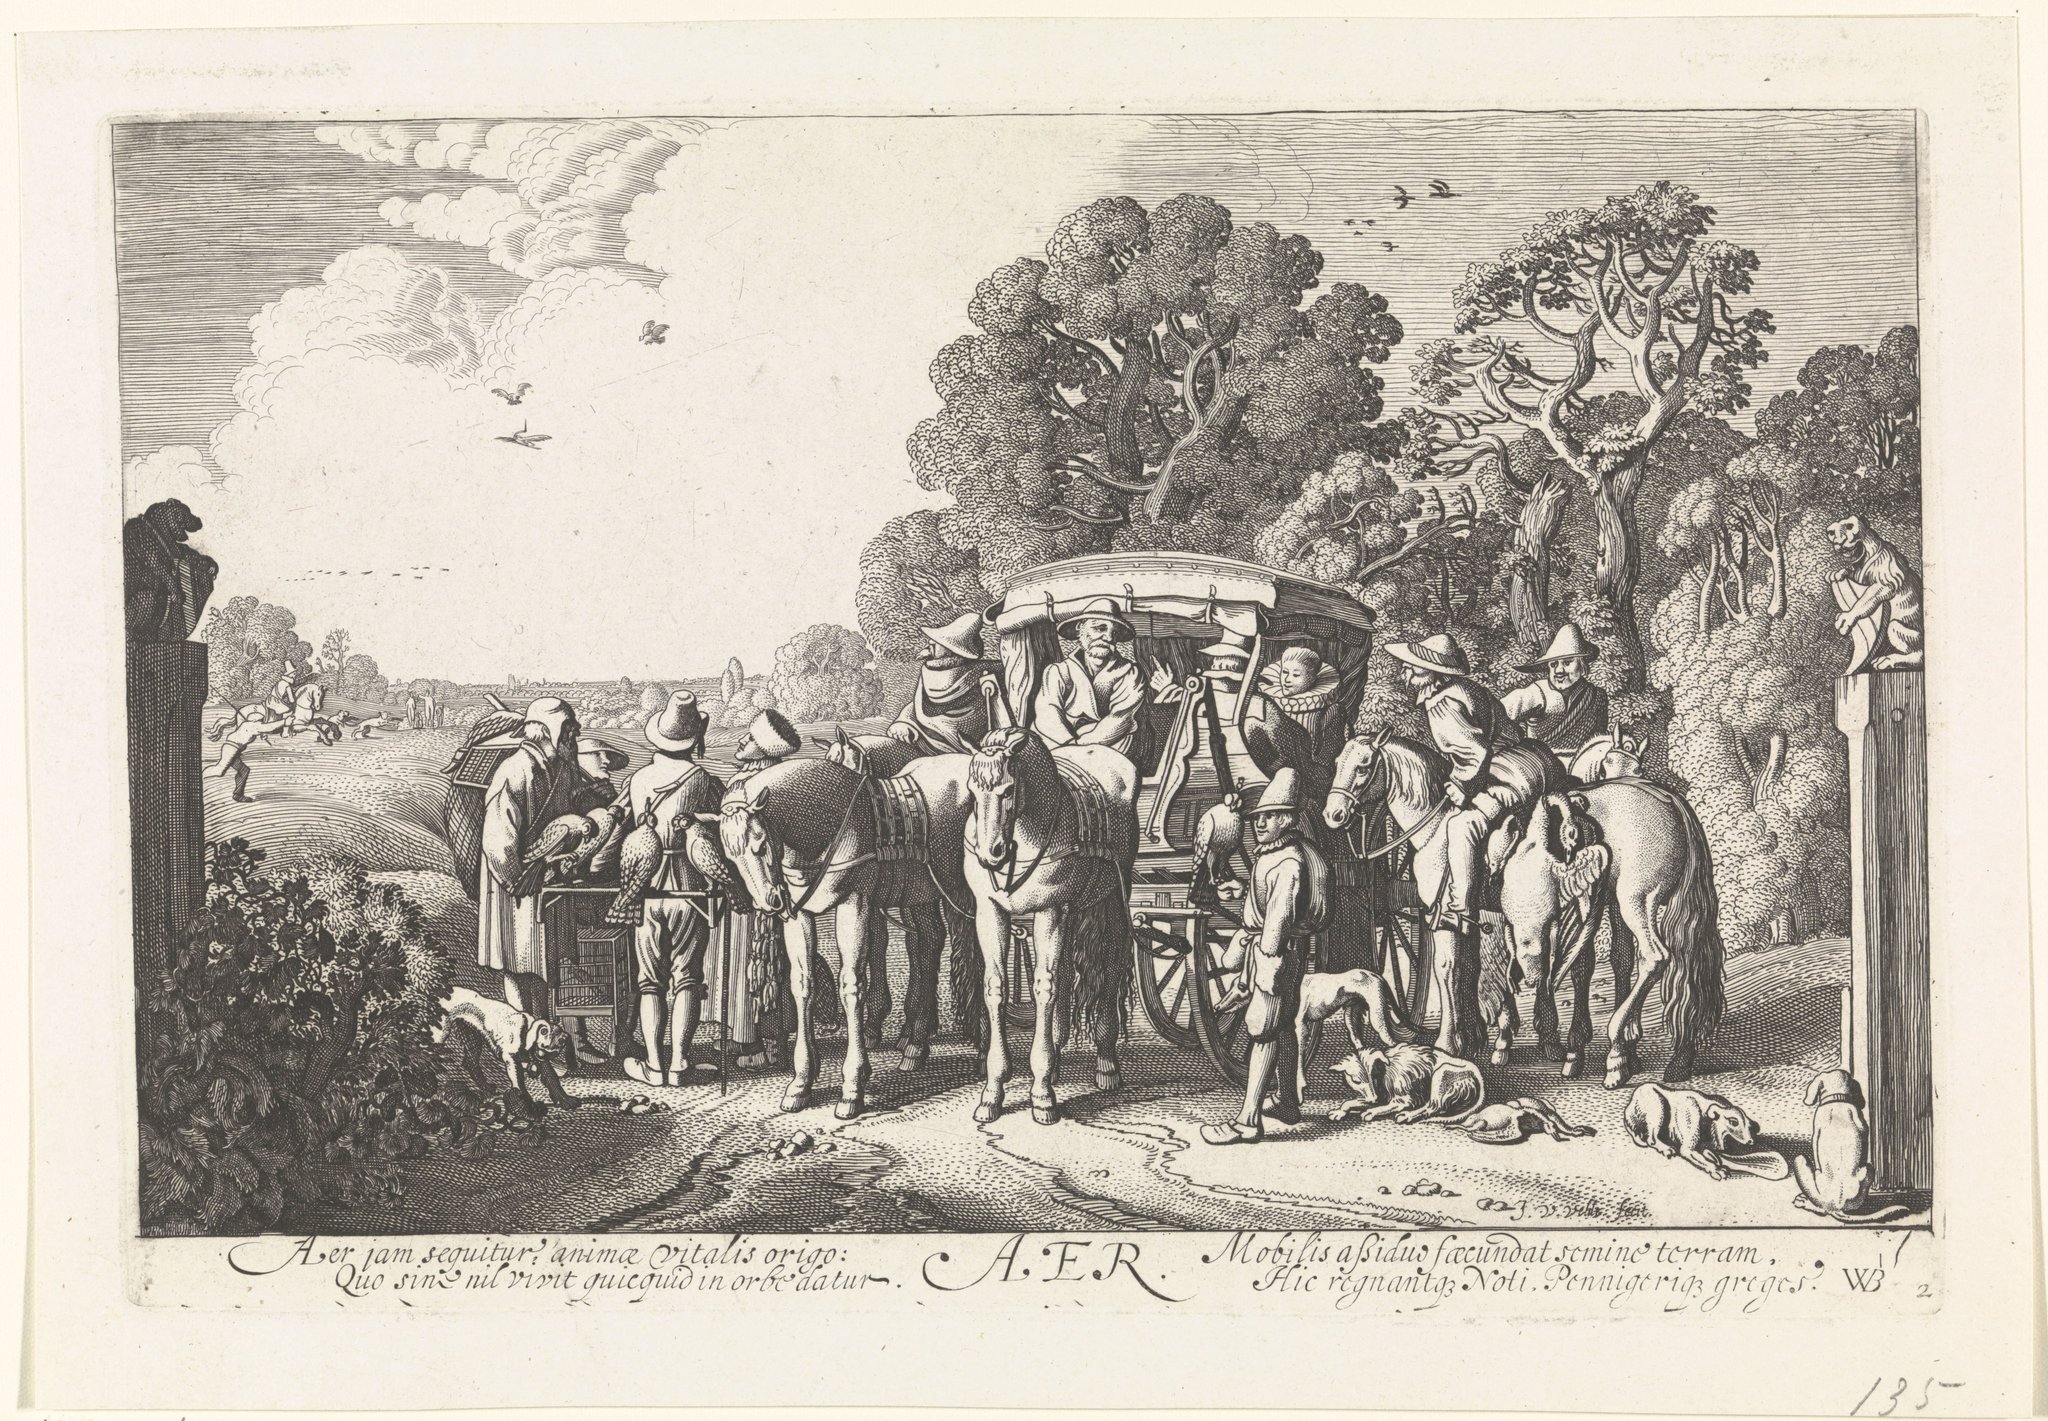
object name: print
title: Lucht (Aer)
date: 1603-1641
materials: paper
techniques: engraving, etching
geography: northern netherlands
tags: predatory birds: falcon, hunting, chase, air (one of the four elements), game, hunted animals, bird hunting, four-wheeled vehicle drawn by two animals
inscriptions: signature: ‘J.V. Velde fecit’, signature: ‘WB’, title: ‘Aer jam seguitur...Pennigerique greges.’, collector's mark: Lugt 2228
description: Landschap met figuren tijdens een valkenjacht voorstellende het element lucht. Op een landweg staat een stilstaande reiskoets met twee paarden ervoor. Een groep valkeniers eromheen. Tweede prent uit een serie van vier met landschappen als verbeeldingen van de vier elementen.